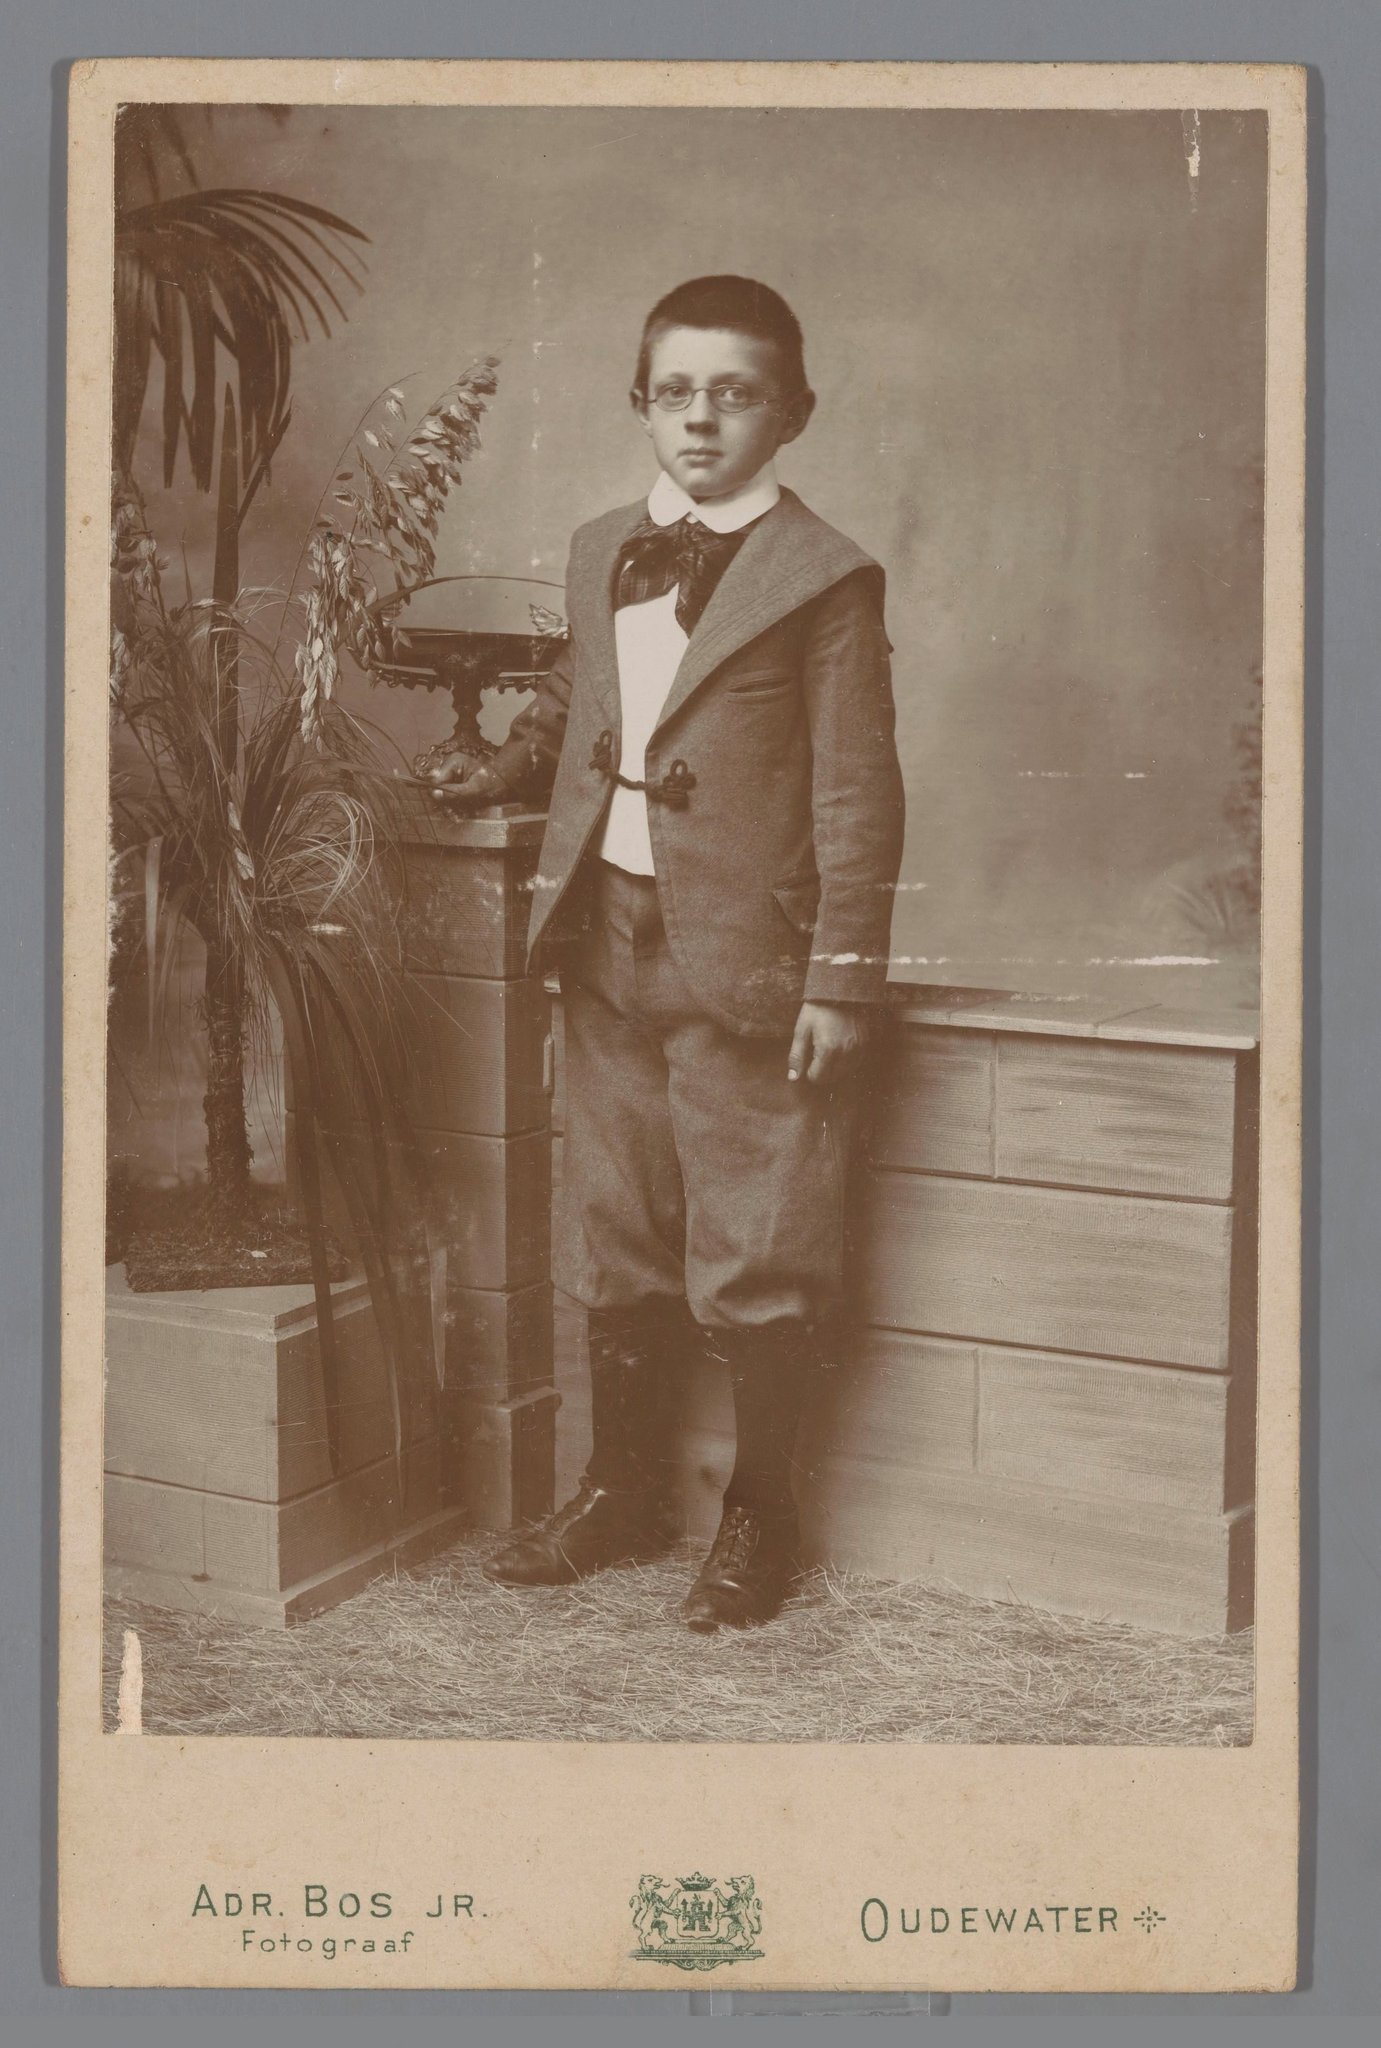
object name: cabinet photograph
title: Portret van een onbekende jongen met een bril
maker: adriaan bos jr.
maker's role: fotograaf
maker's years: 1869-1940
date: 1893-1900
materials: cardboard, photographic support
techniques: collodion silver print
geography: oudewater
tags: eyeglasses, spectacles, boy (child between toddler and youth)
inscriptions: name: ‘Fotografisch Kunst-Atelier Adr. Bos Jr. Oudewater. Specialiteit in onveranderlyke vergrootingen en het reproduceeren van oude verbleekte portretten. De platen blyven voor nabestelling bewaard.’